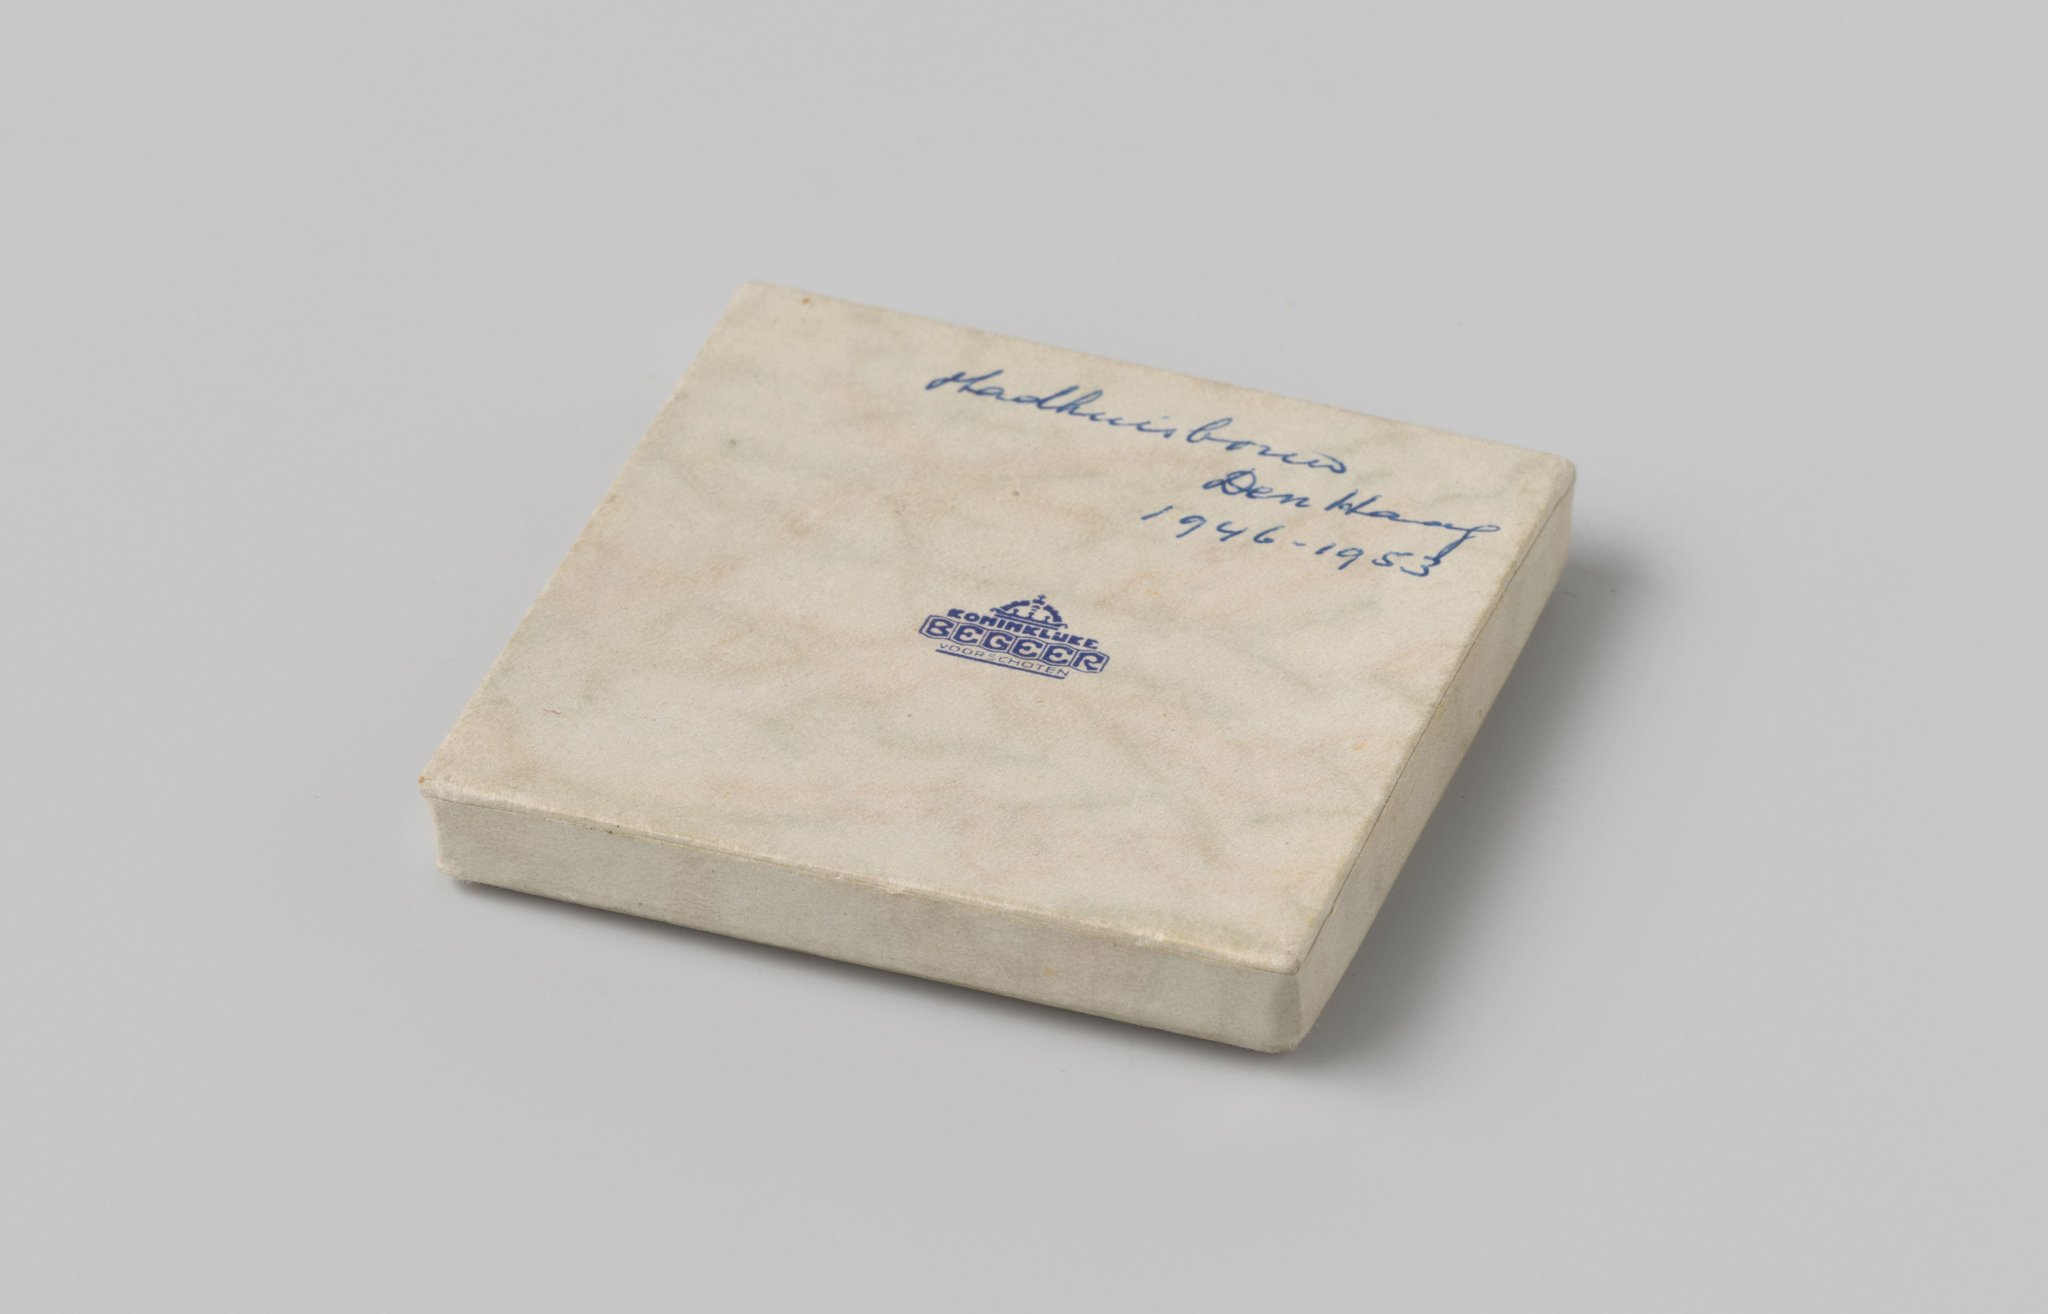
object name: box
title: Doos behorend bij een penning ter ere van Alkmaar 700 jaar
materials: cardboard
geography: voorschoten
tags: amsterdam, the hague, willem drees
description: Een wit vierkant kartonnen doosje met op deksel NV Koninklijke Begeer, Voorschoten.